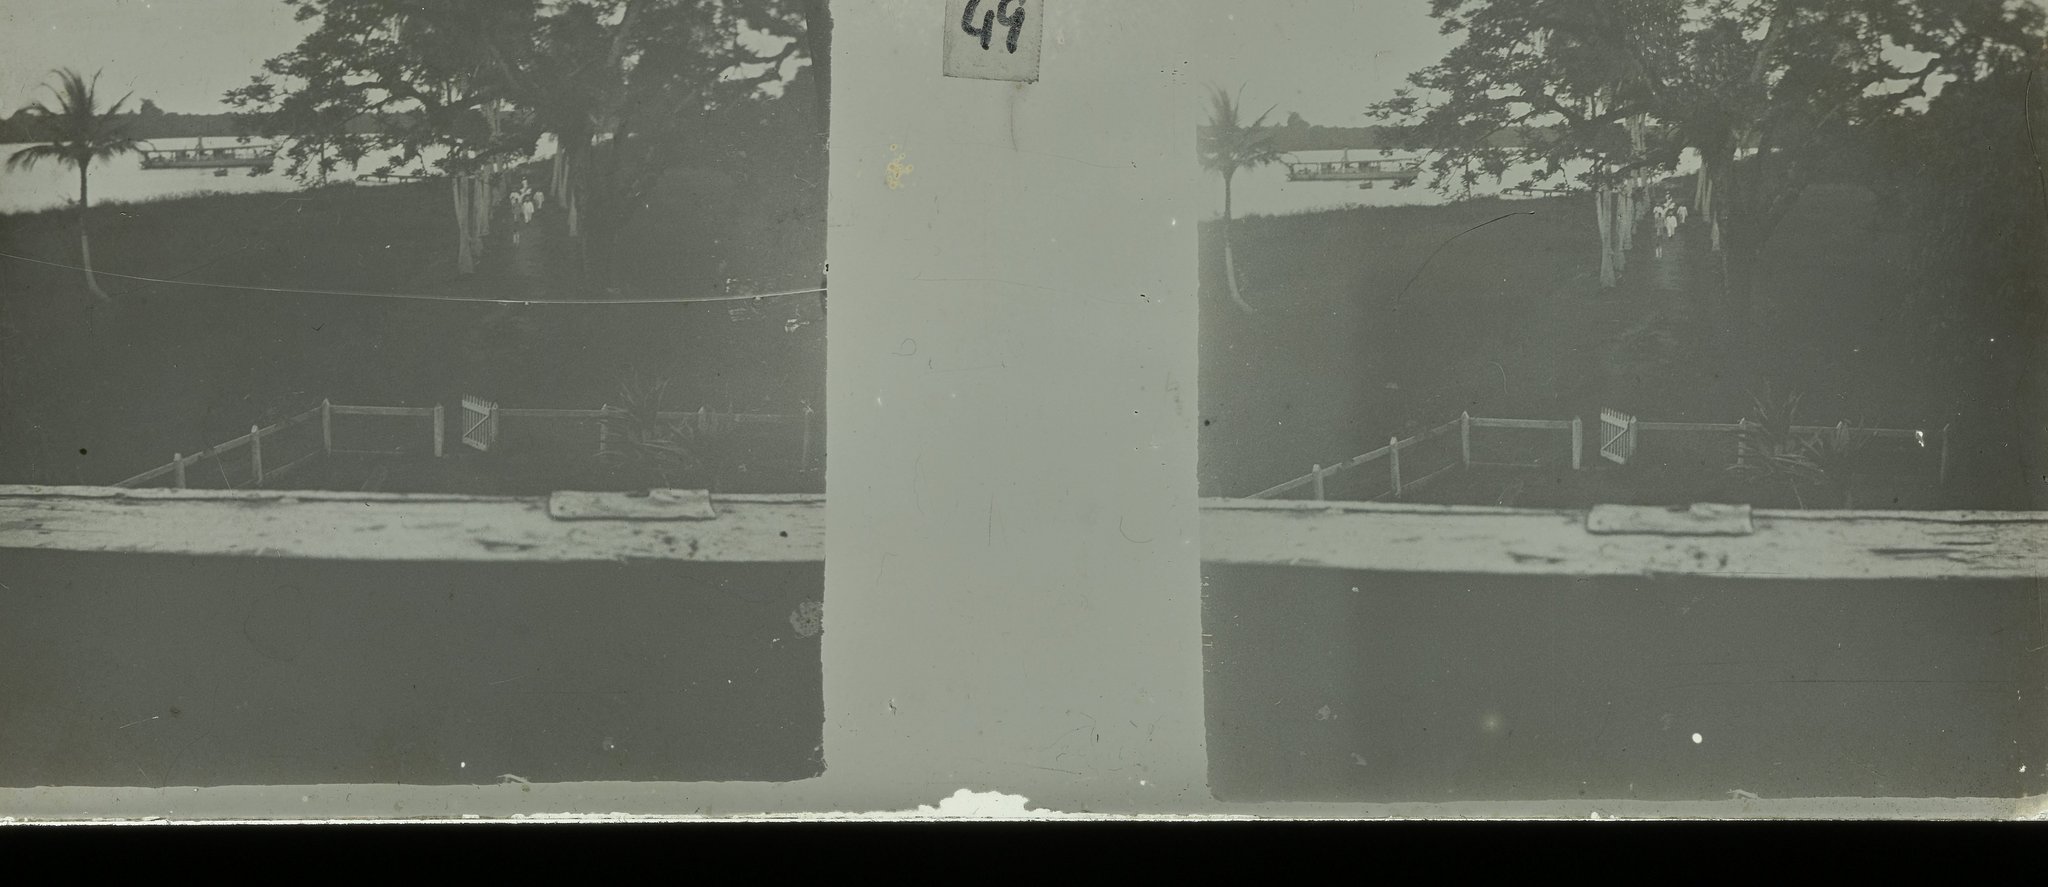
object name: stereograph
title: Laantje naar het woonhuis van Plantage Accaribo, met de rivierboot Prins Hendrik op de achtergrond.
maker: theodoor brouwers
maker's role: amateurfotograaf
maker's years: 1874-1932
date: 1913-1930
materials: glass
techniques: photography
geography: suriname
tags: amsterdam, theodoor brouwers, plantation, suriname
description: In de periode 1911-1932 woonde op plantage Accaribo in Suriname de familie Brouwers van wie de foto's afkomstig zijn. Rond 1910 vond Theodoor Brouwers werk op plantage Accaribo. In 1929 werd hij eigenaar van de plantage. Op Accaribo werden in zijn tijd bananen geproduceerd en wat koffie.